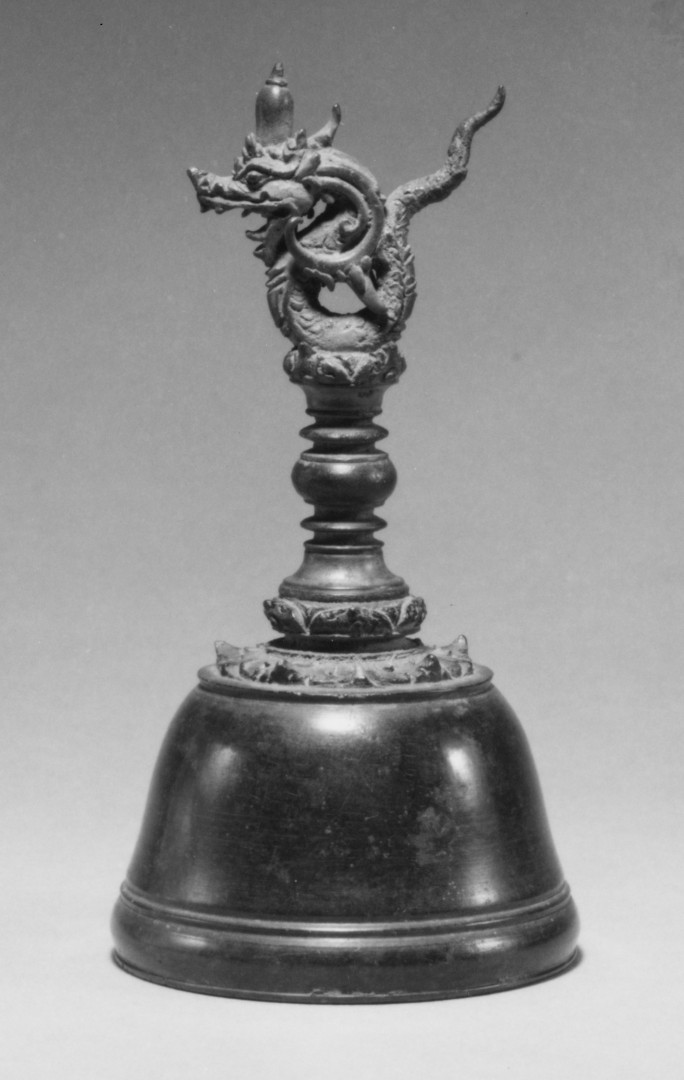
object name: bell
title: Hand Bell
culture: indonesian, javanese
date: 1201-1400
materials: bronze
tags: musical instruments,dragons